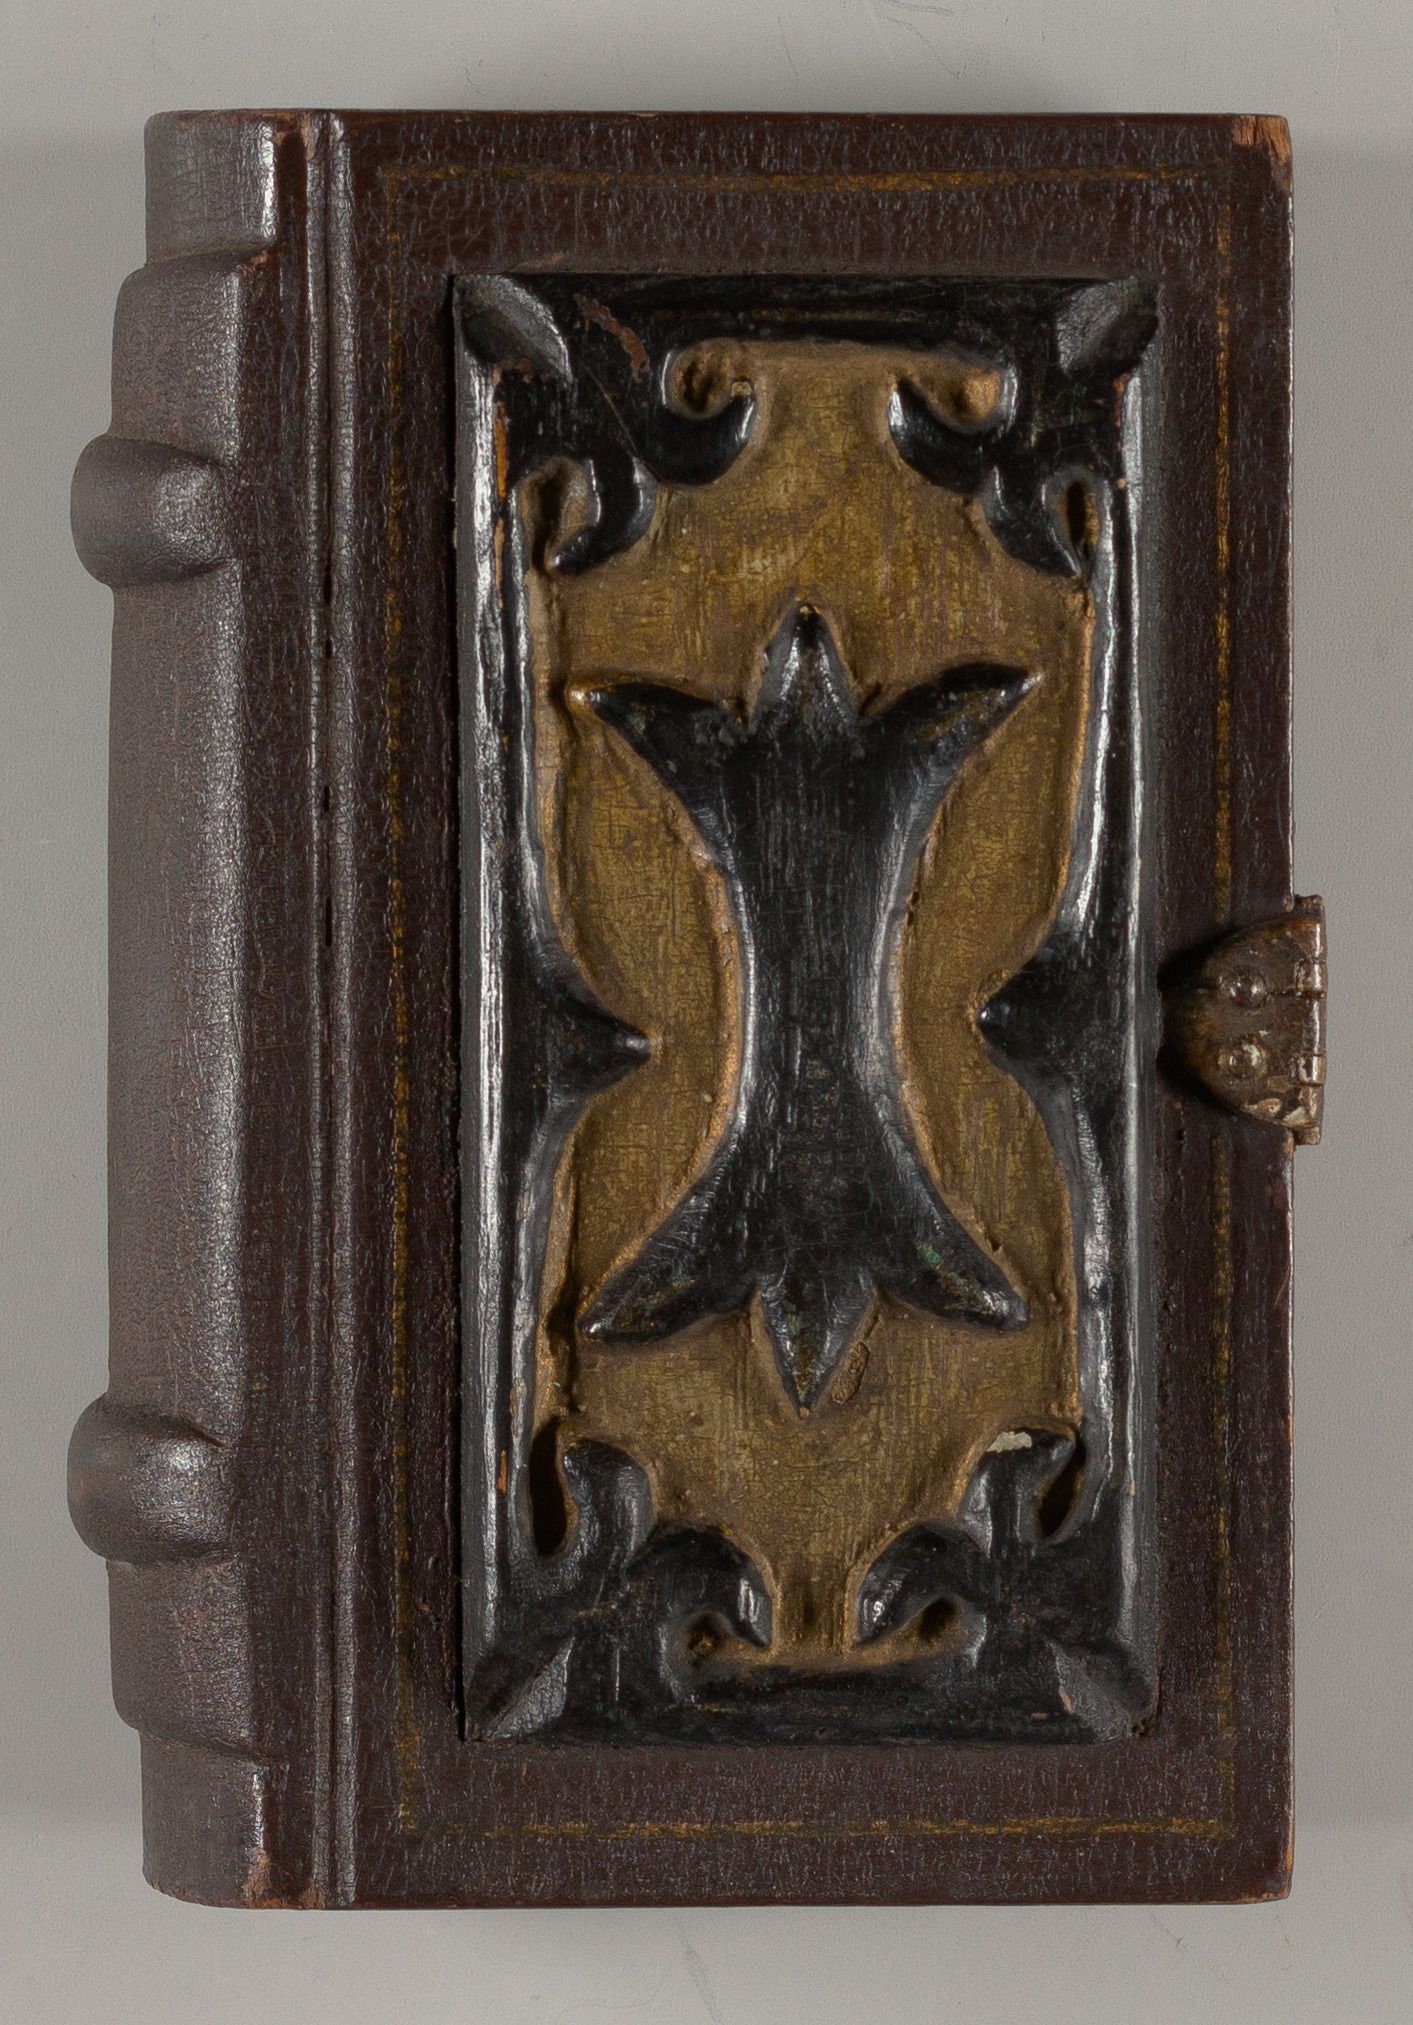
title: Relief-carved solid book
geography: united states